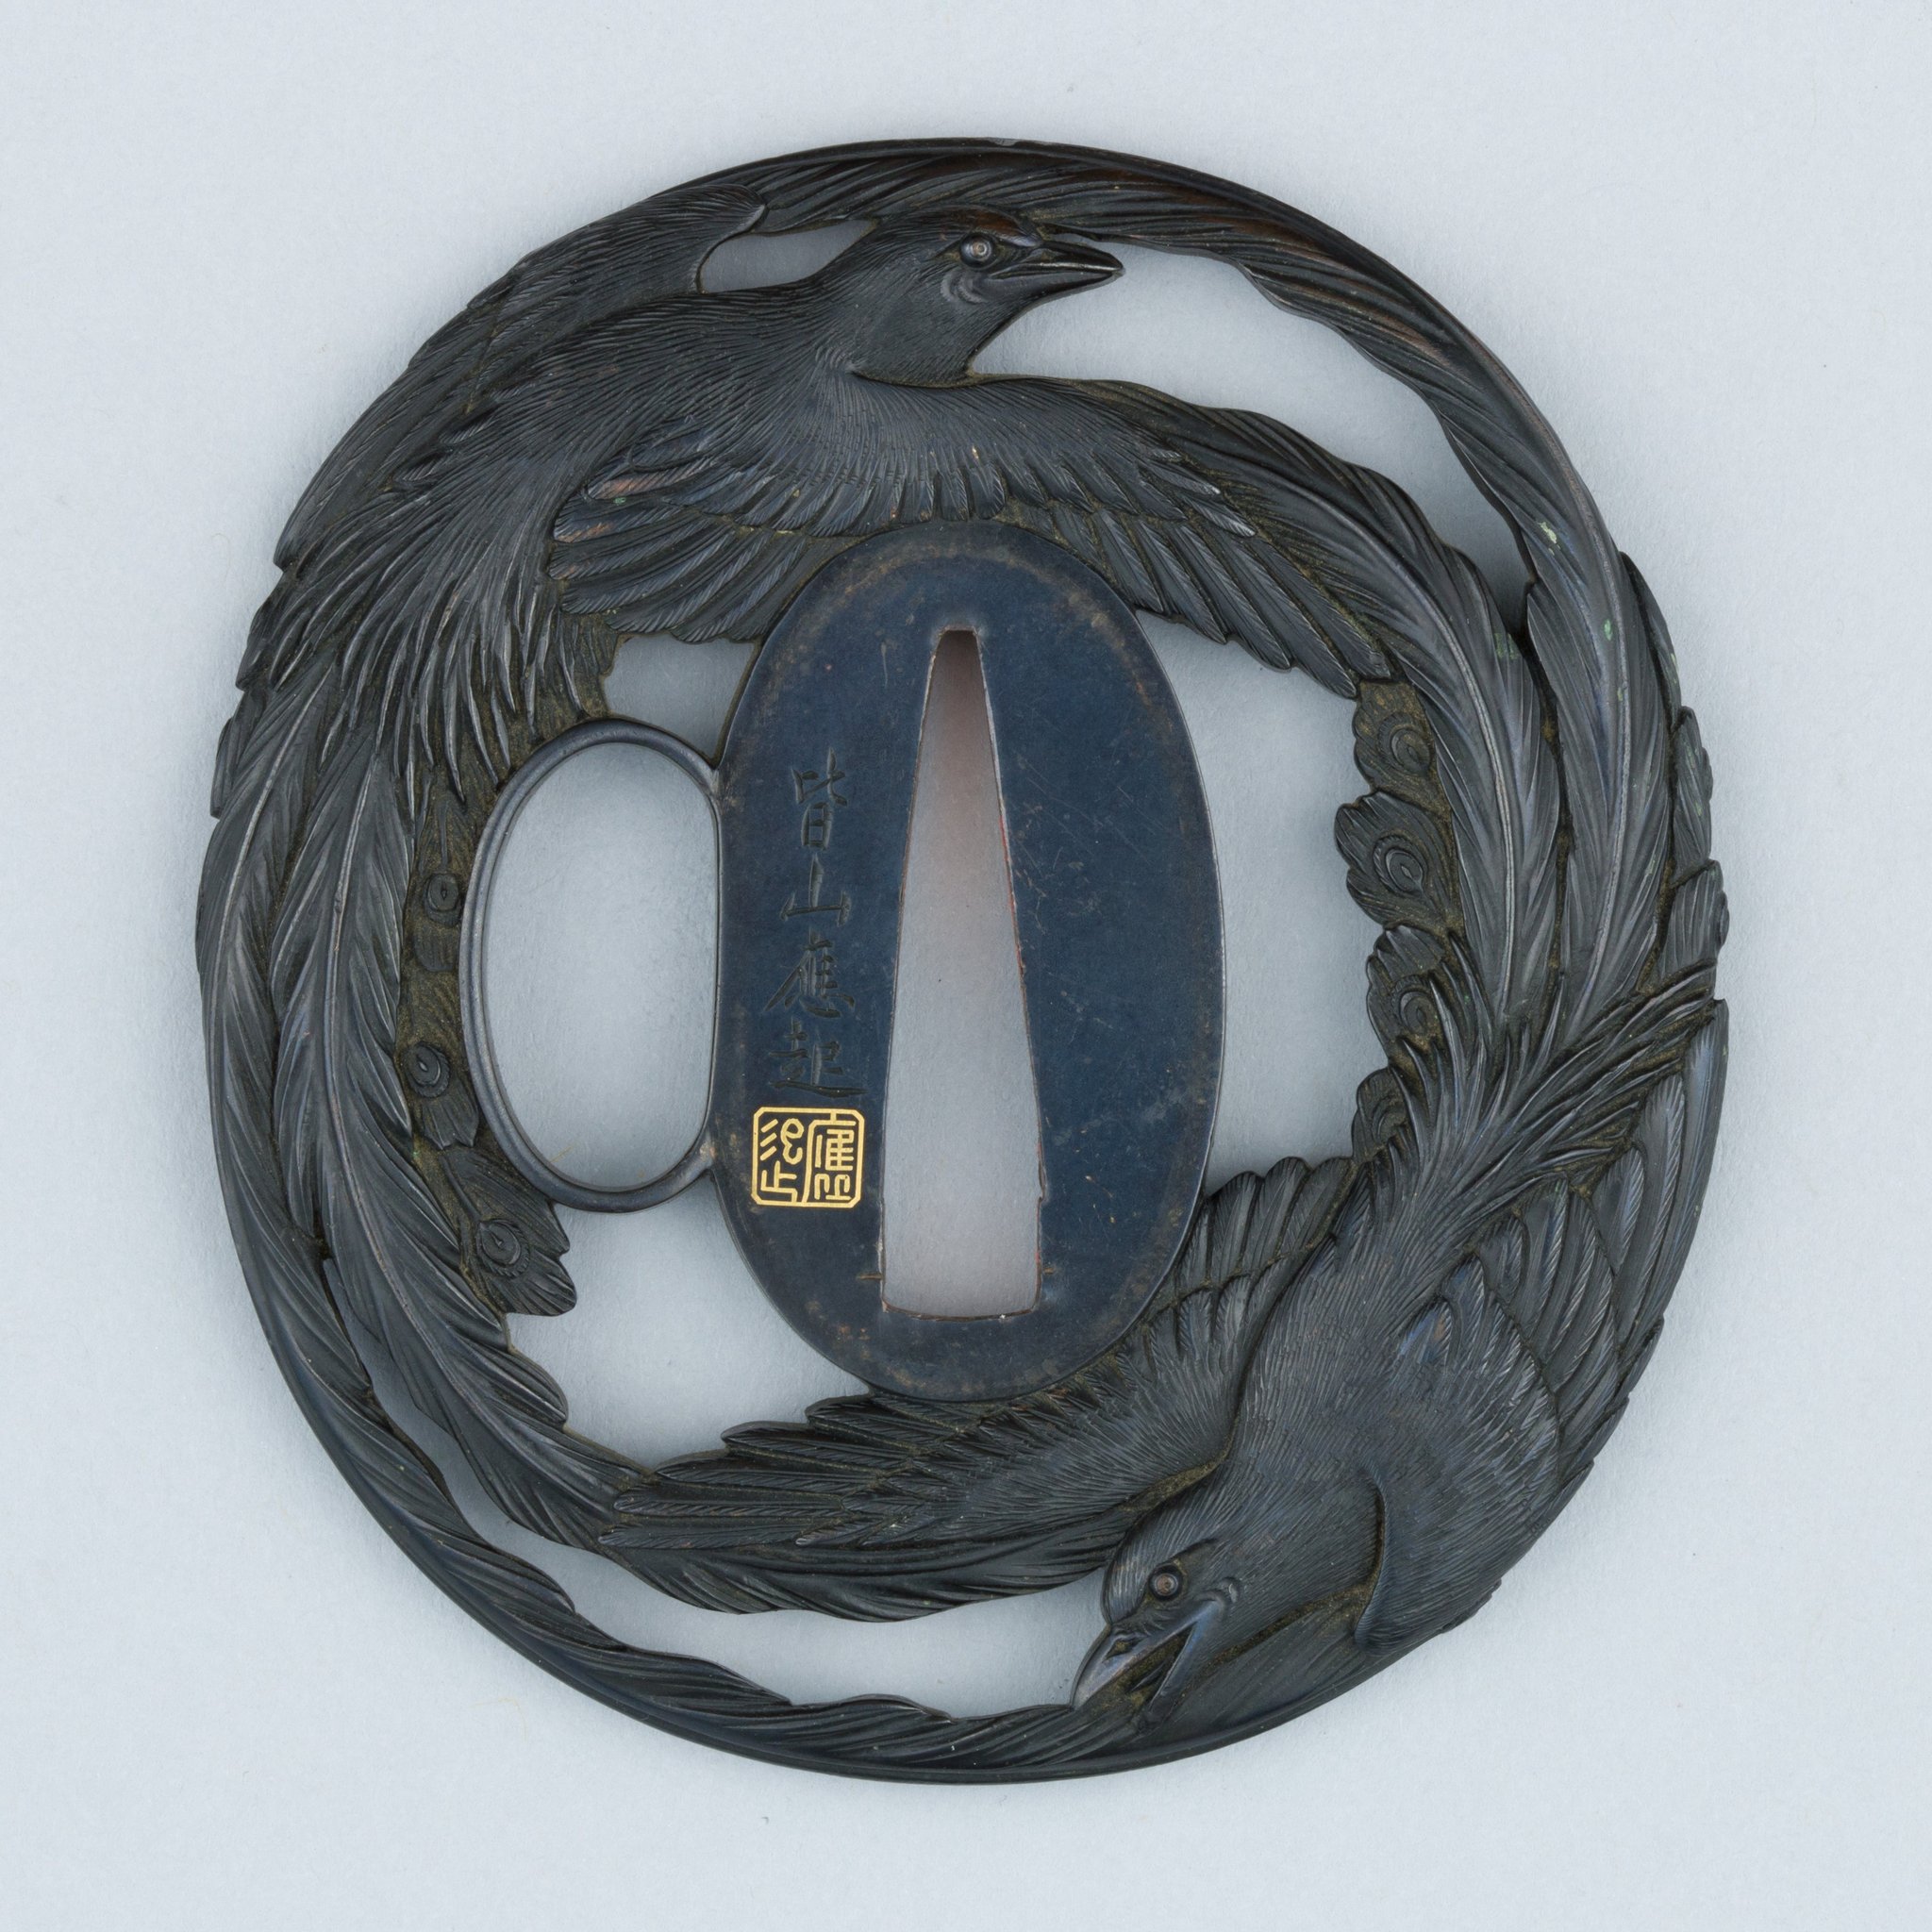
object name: sword guard tsuba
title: Sword Guard (Tsuba)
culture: japanese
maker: minayama ōki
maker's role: fittings maker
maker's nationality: japanese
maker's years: 1701-1800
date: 1701-1800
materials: copper, gold alloy, gold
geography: japan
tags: birds